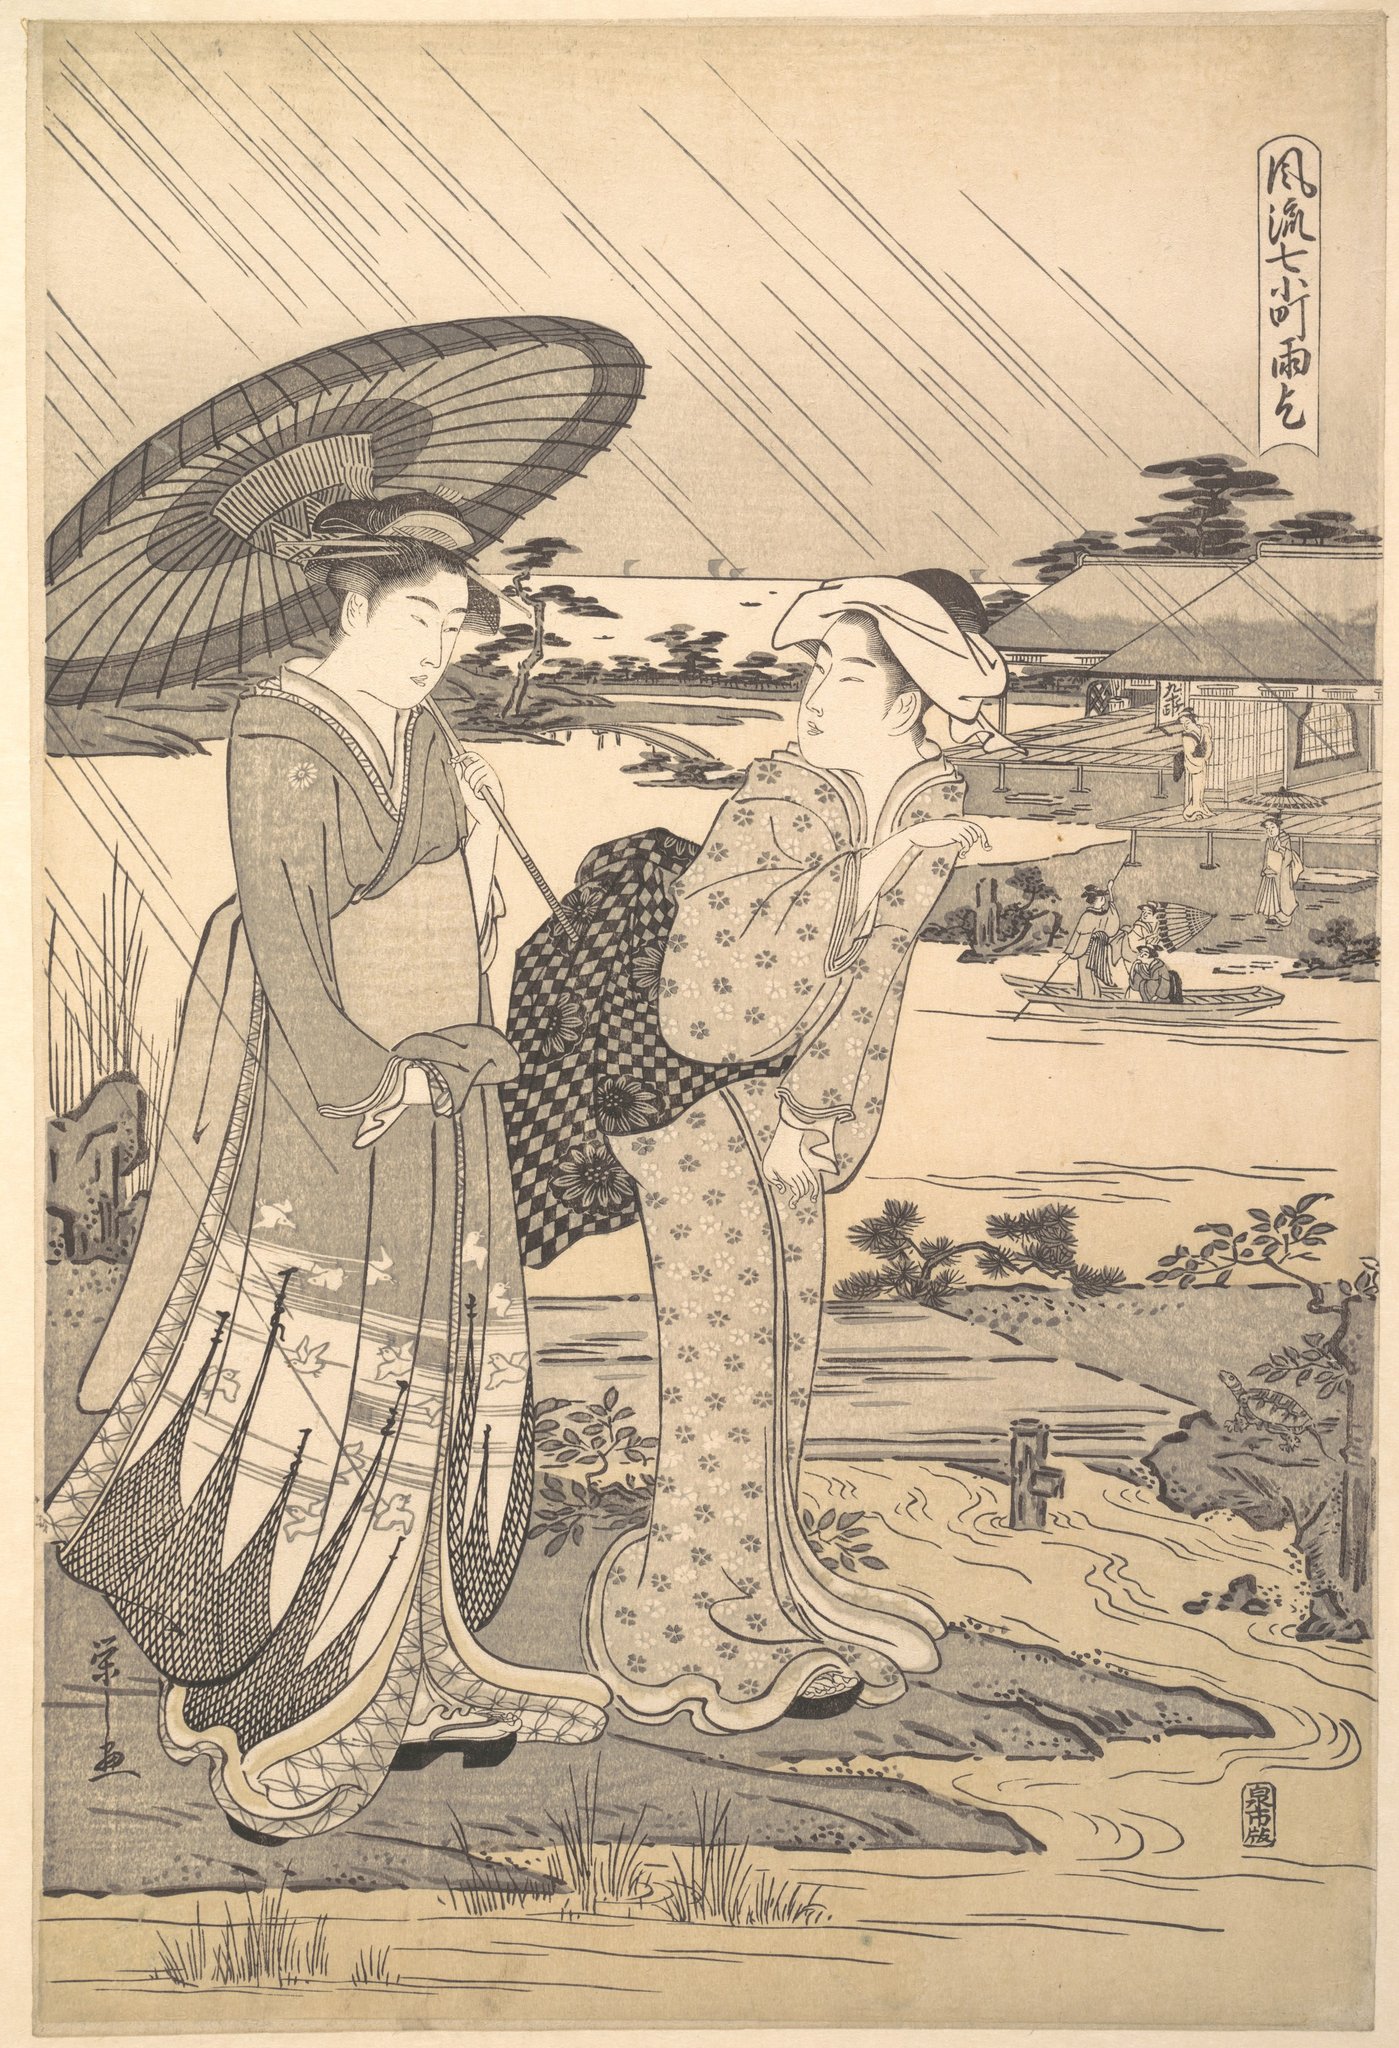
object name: print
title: Ono no Komachi Praying for Rain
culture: japanese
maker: chōbunsai eishi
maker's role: artist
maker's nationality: japanese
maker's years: 1756-1829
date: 1791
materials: ink, paper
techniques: woodblock print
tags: women,rain,servants,umbrellas